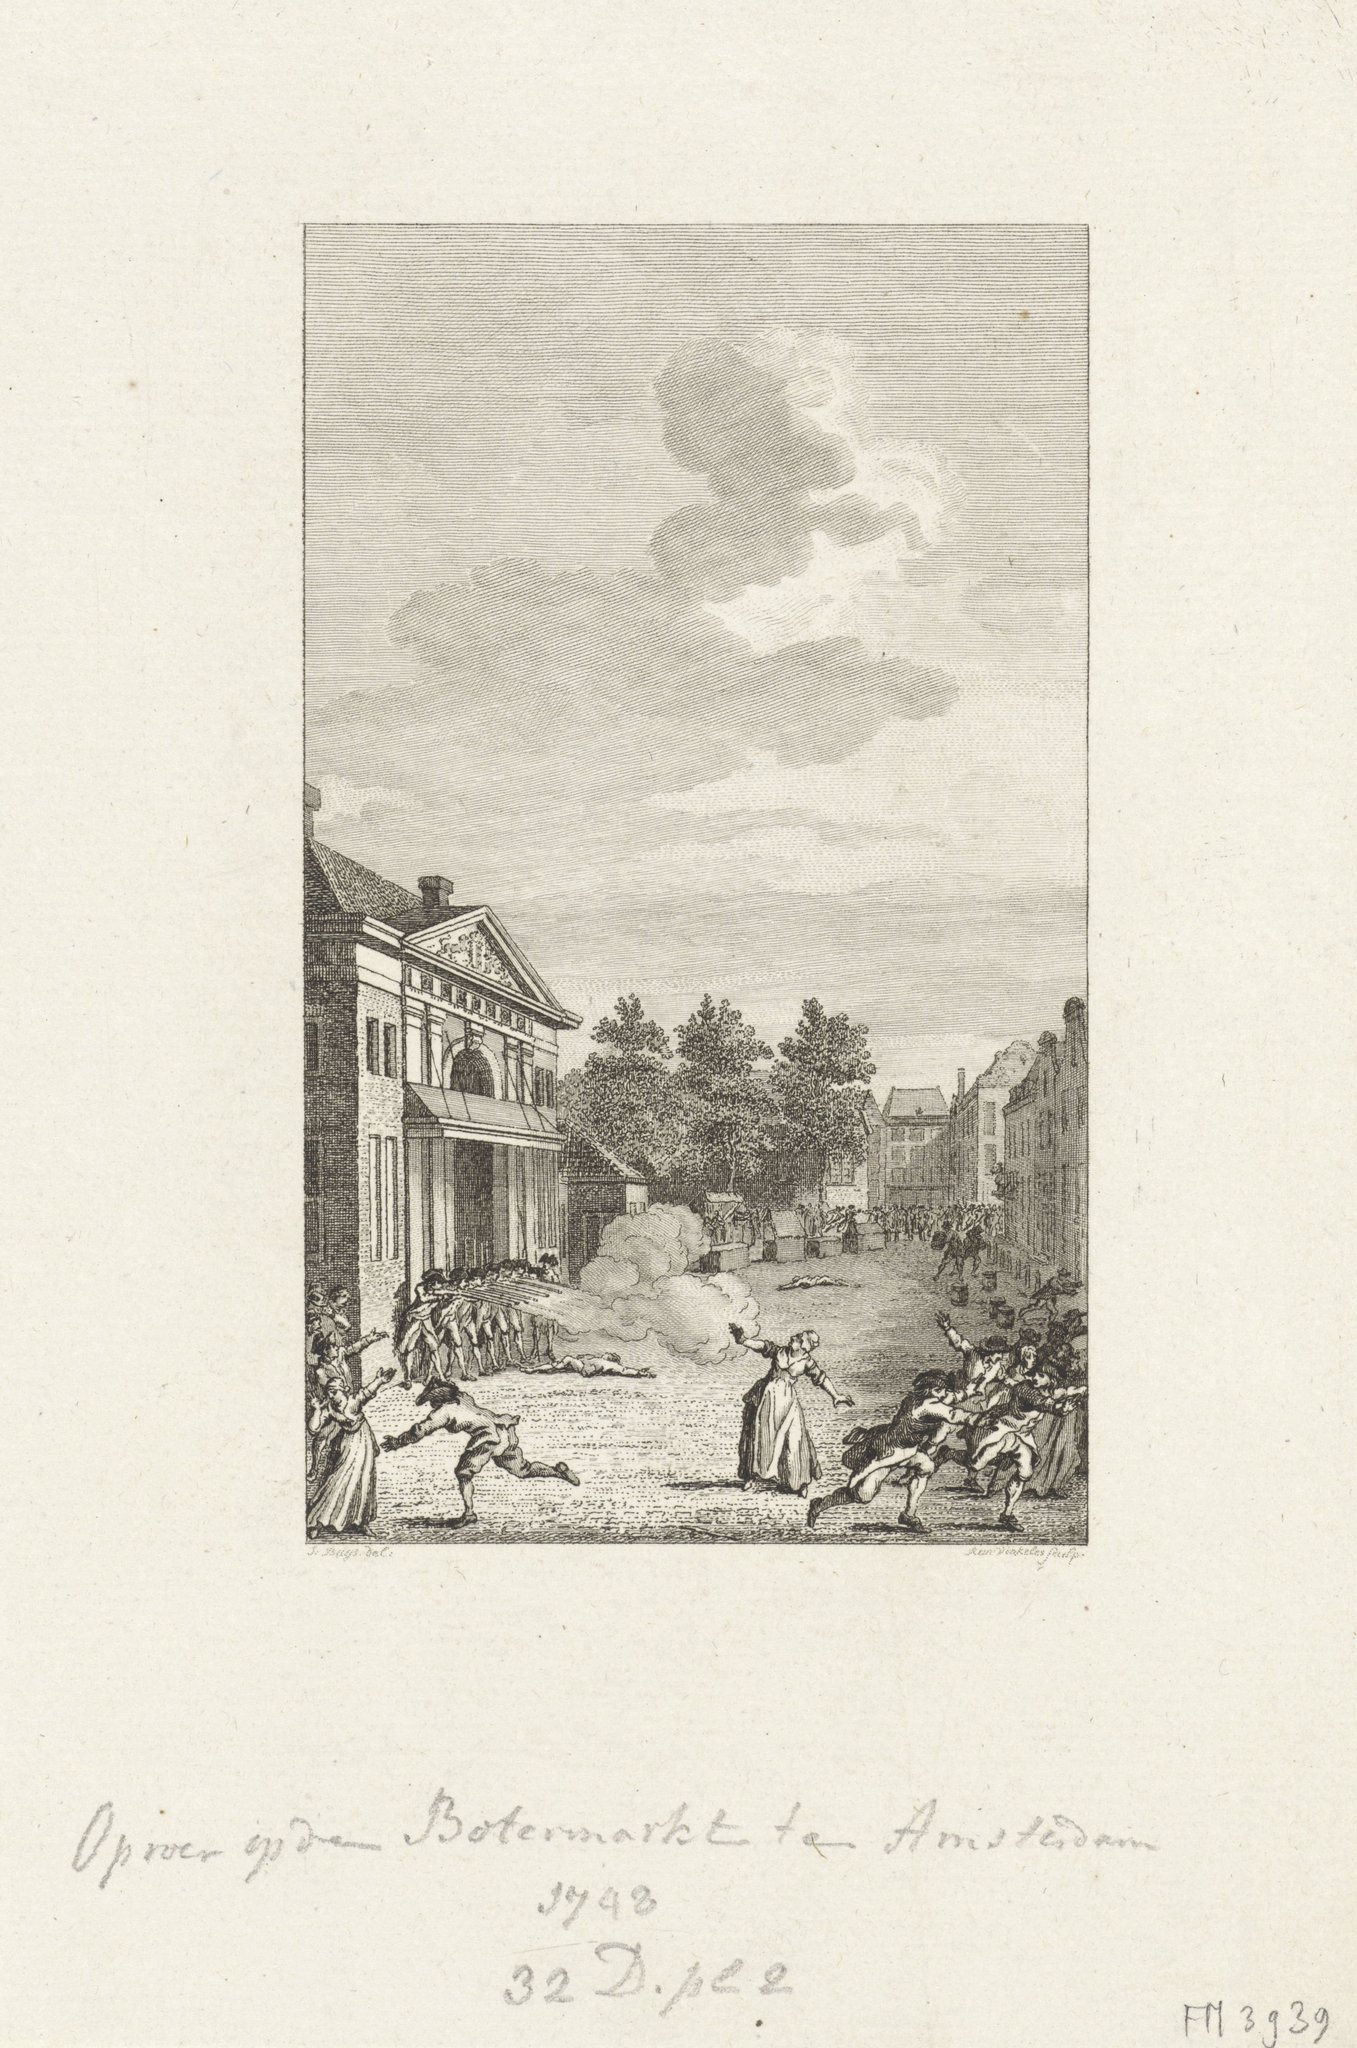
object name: print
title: Oproer op de Botermarkt te Amsterdam 1748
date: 1794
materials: paper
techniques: etching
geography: amsterdam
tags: street-fights, riots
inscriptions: collector's mark: Lugt 240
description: Oproer op de Botermarkt te Amsterdam 1748. Soldaten staande voor het Waaggebouw (Regulierswaag of Boterwaag) schieten op rellende burgers.